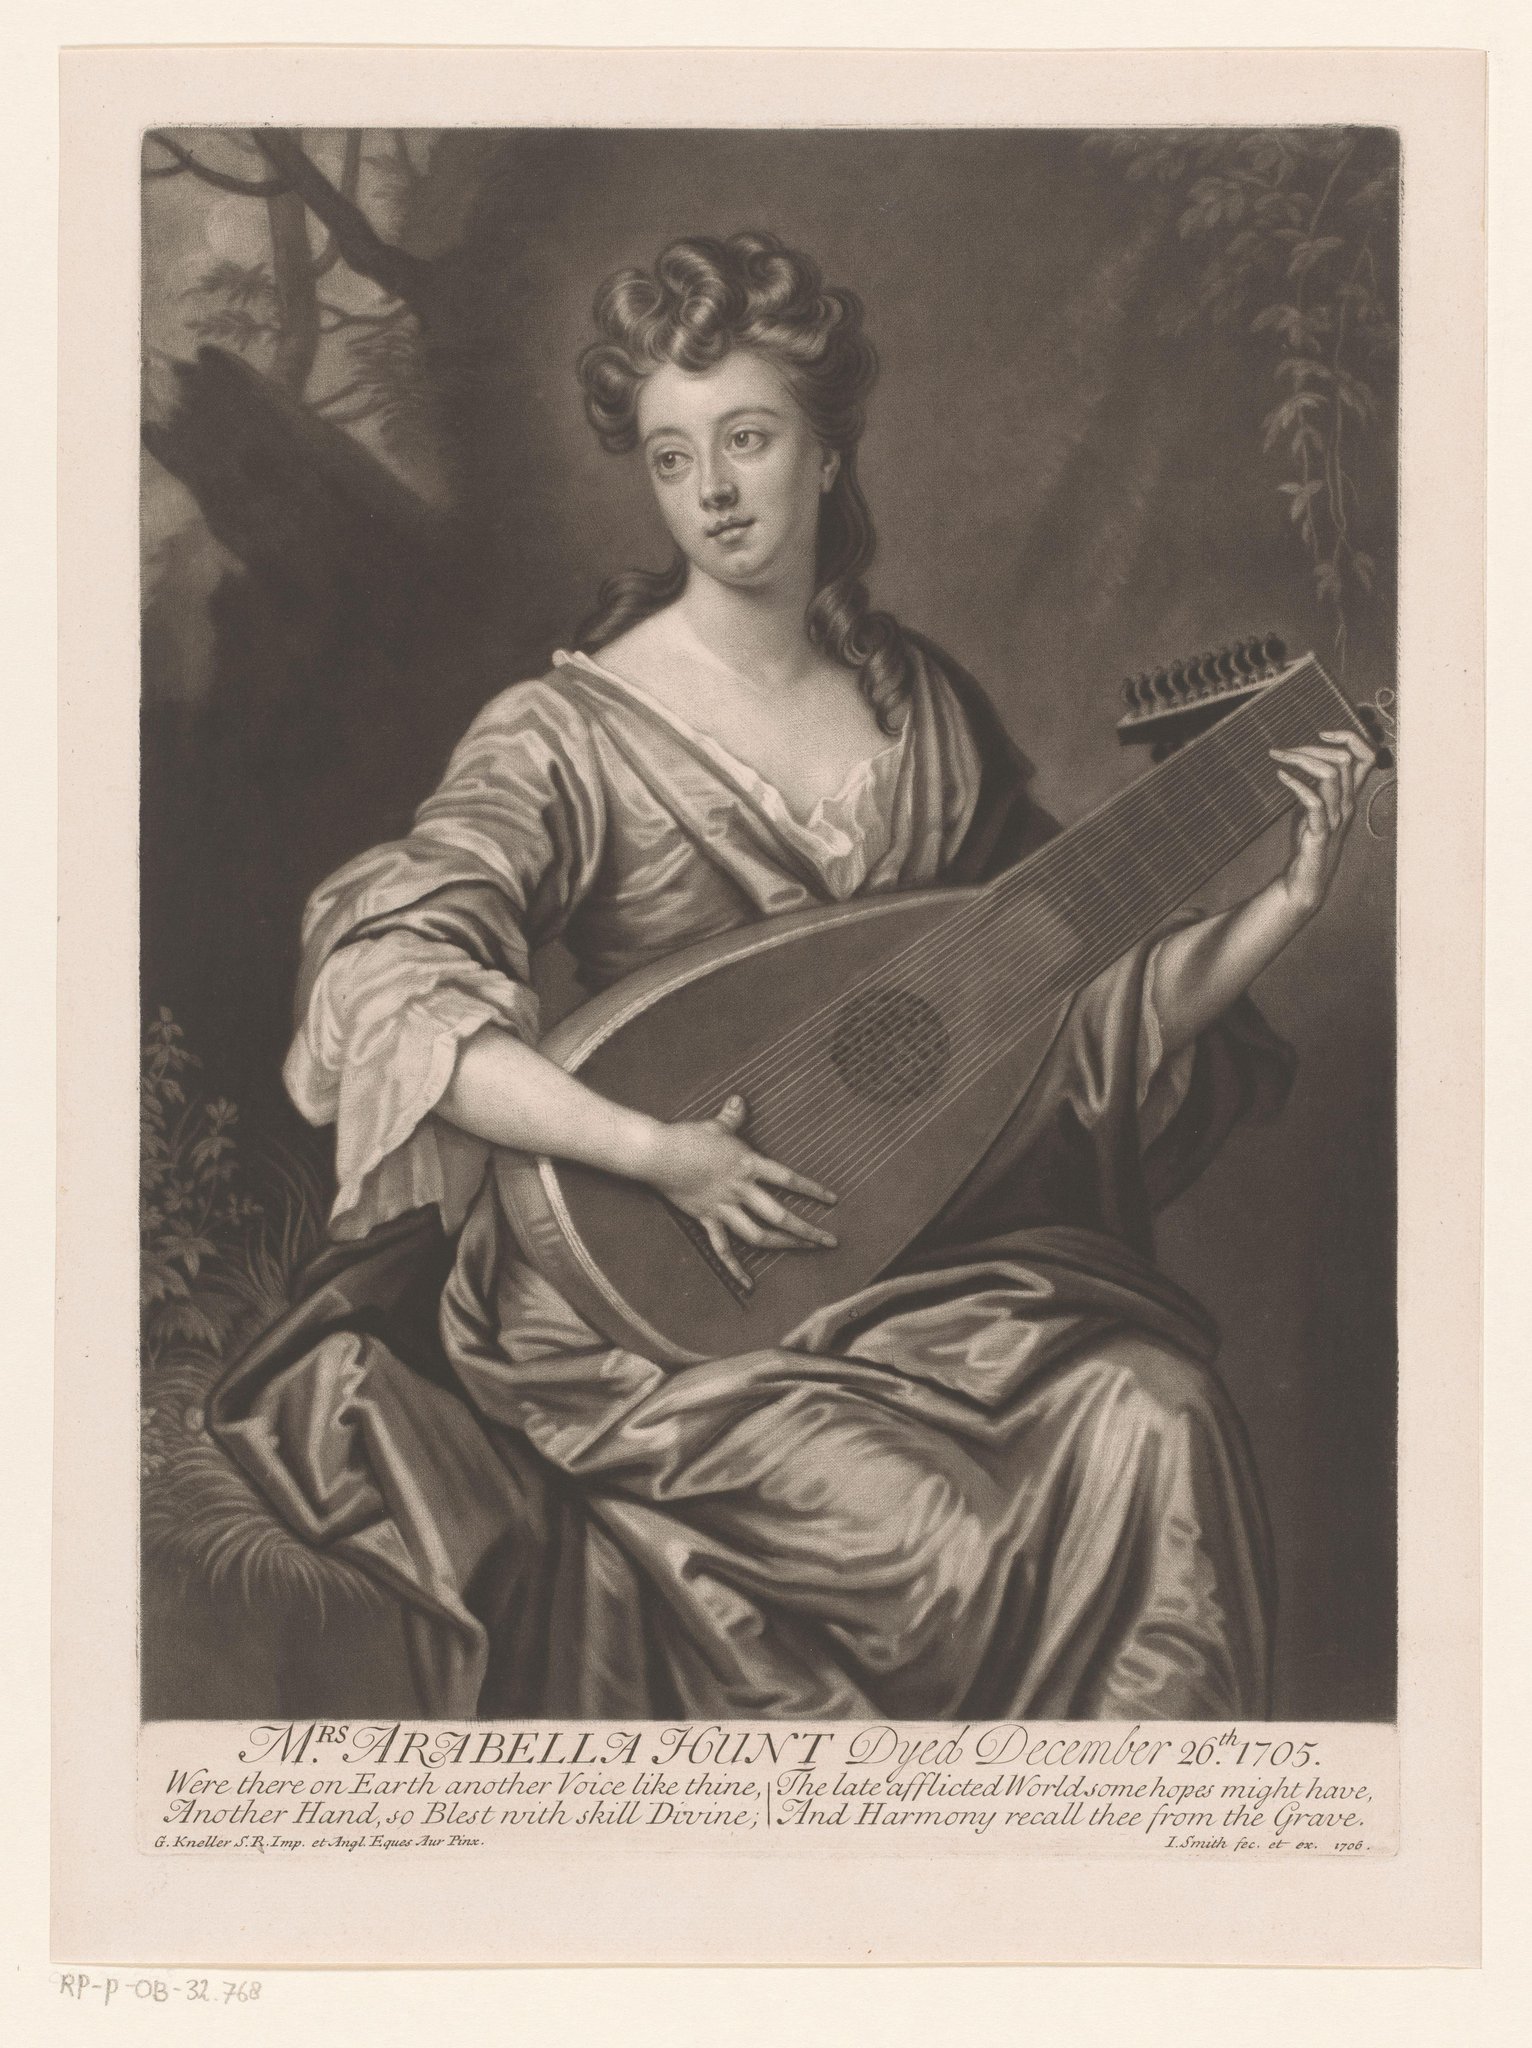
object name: print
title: Portrait of Arabella Hunt (1662-1705)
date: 1706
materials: paper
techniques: mezzotint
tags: musician, female singer - cc - out of doors, historical persons, lute, and special forms of lute, e.g.: theorbo - cc - out of doors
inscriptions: collector's mark: Lugt 240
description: Singer and lutenist Arabella Hunt served at the English court for many years and was much loved by Queen Mary II Stuart (1662-1694). Hunt performed there and gave singing lessons to Mary’s sister, later Queen Anna Stuart (1665-1714). She was famous, and admired and respected by many professionals and contemporaries, including the playwright William Congreve (1670-1729), who wrote the laudatory poem for this print.